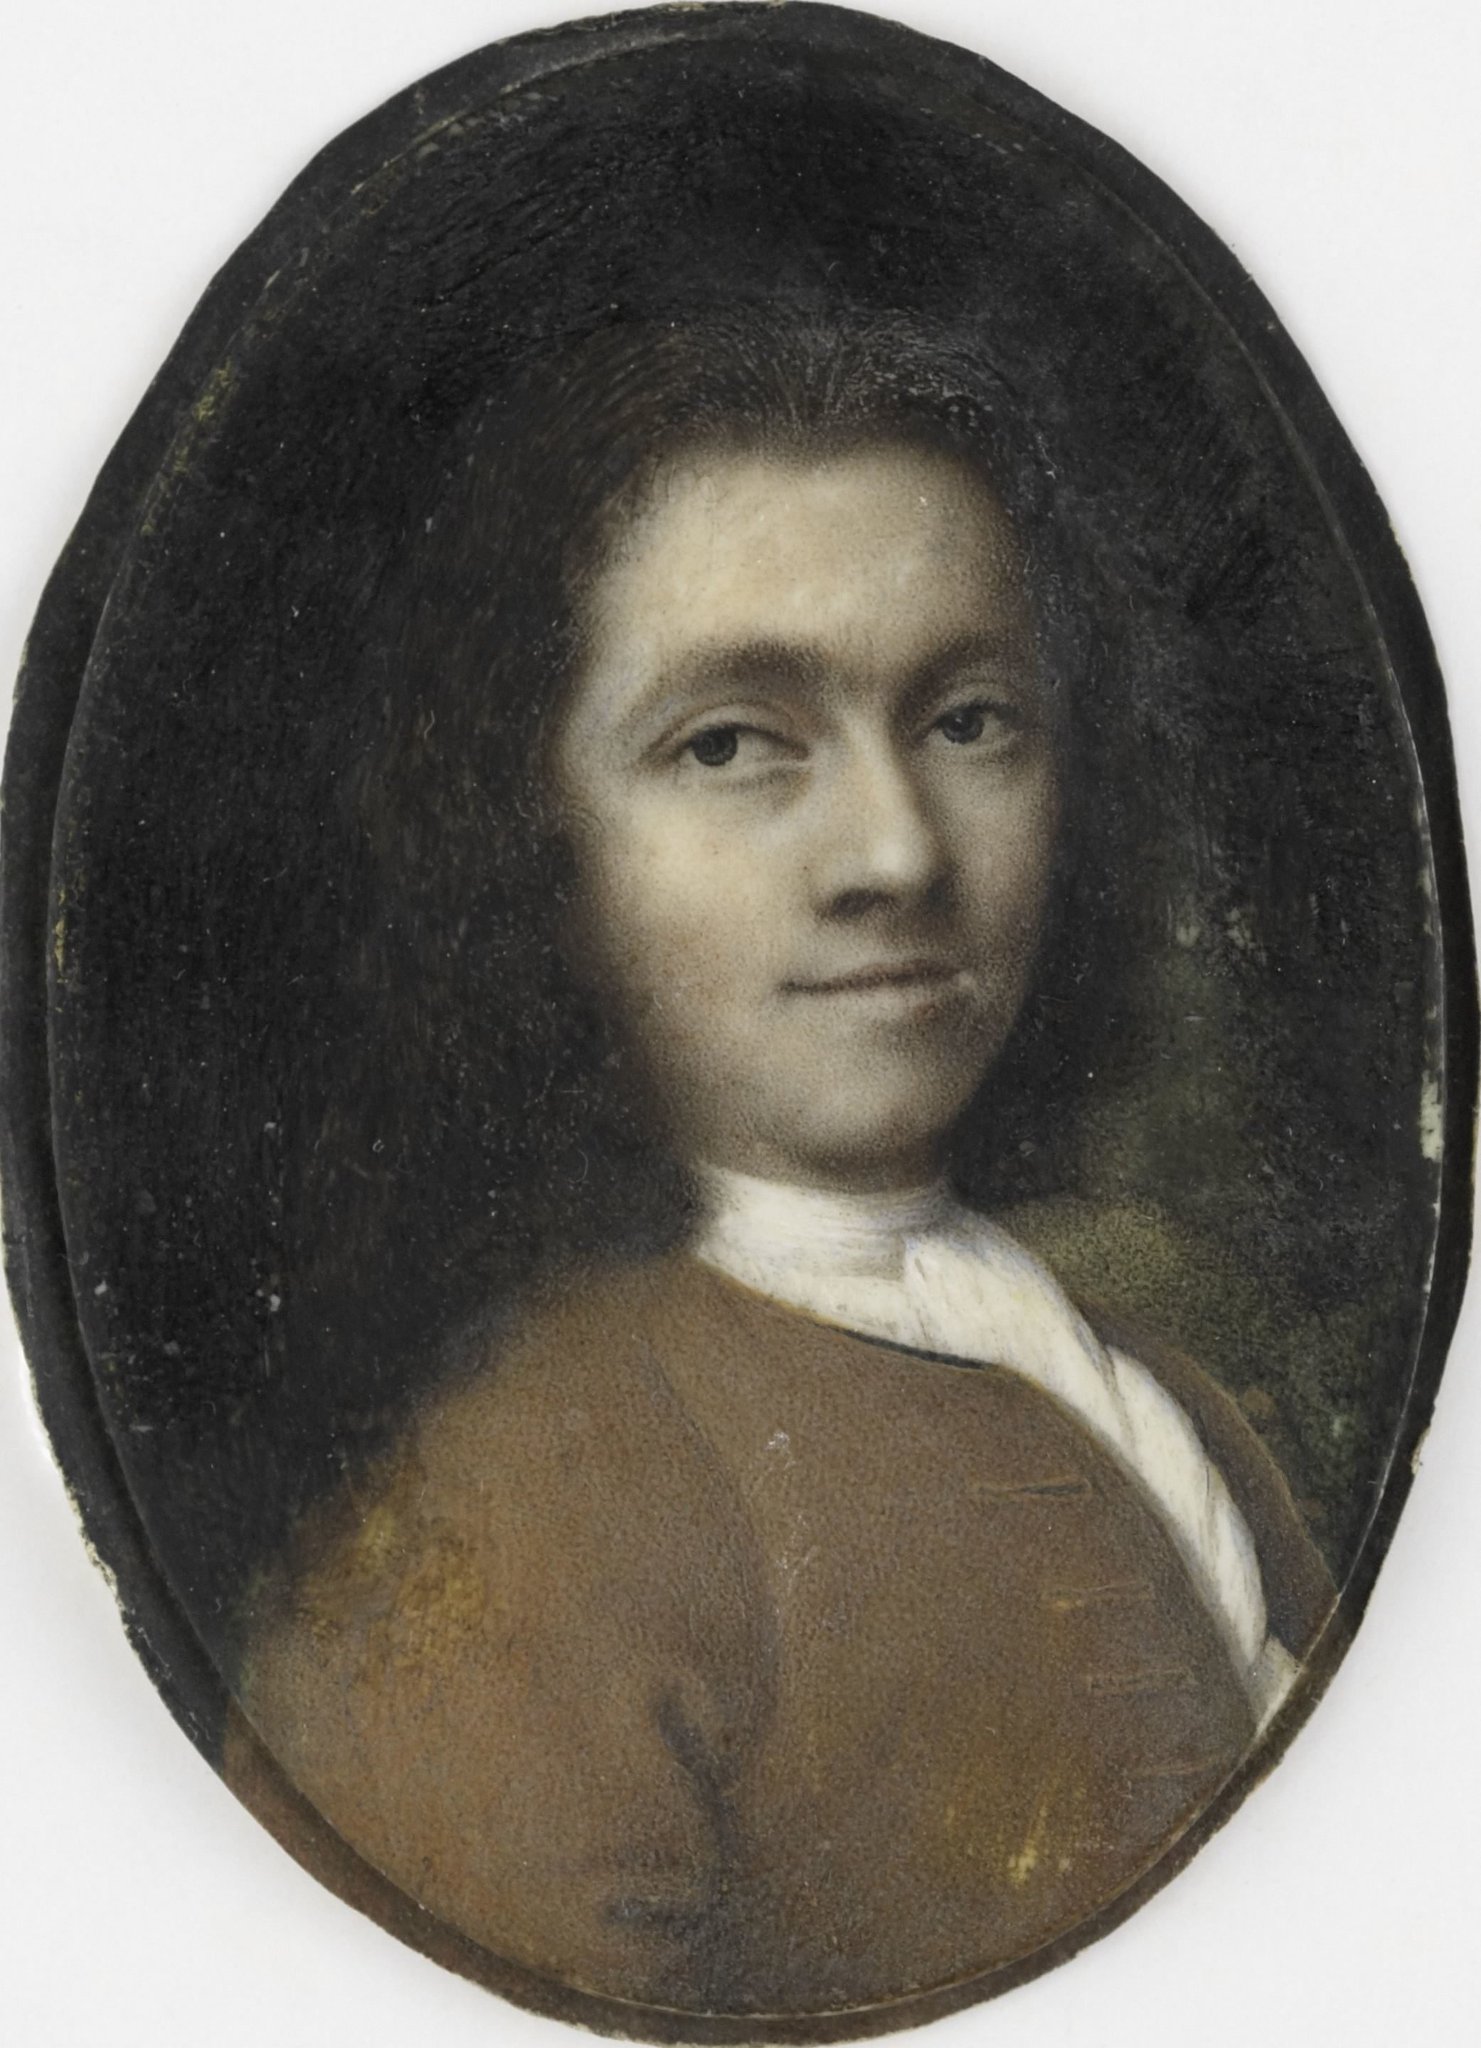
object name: painting, miniature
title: Zelfportret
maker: herman wolters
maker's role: miniatuurschilder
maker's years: 1682-1756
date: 1717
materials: glass, ivory, metal, wood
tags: haarlem, herman wolters, historical persons, portrait, self-portrait of painter, portrait, self-portrait of artist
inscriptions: inscription: ‘Herm. Wolters hemzelf het eerst in Mignatuur geschildert 1717. Geboren 1682’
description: Hermanus Wolters (1682 - 1756). Self portrait. Ivory, 1717.